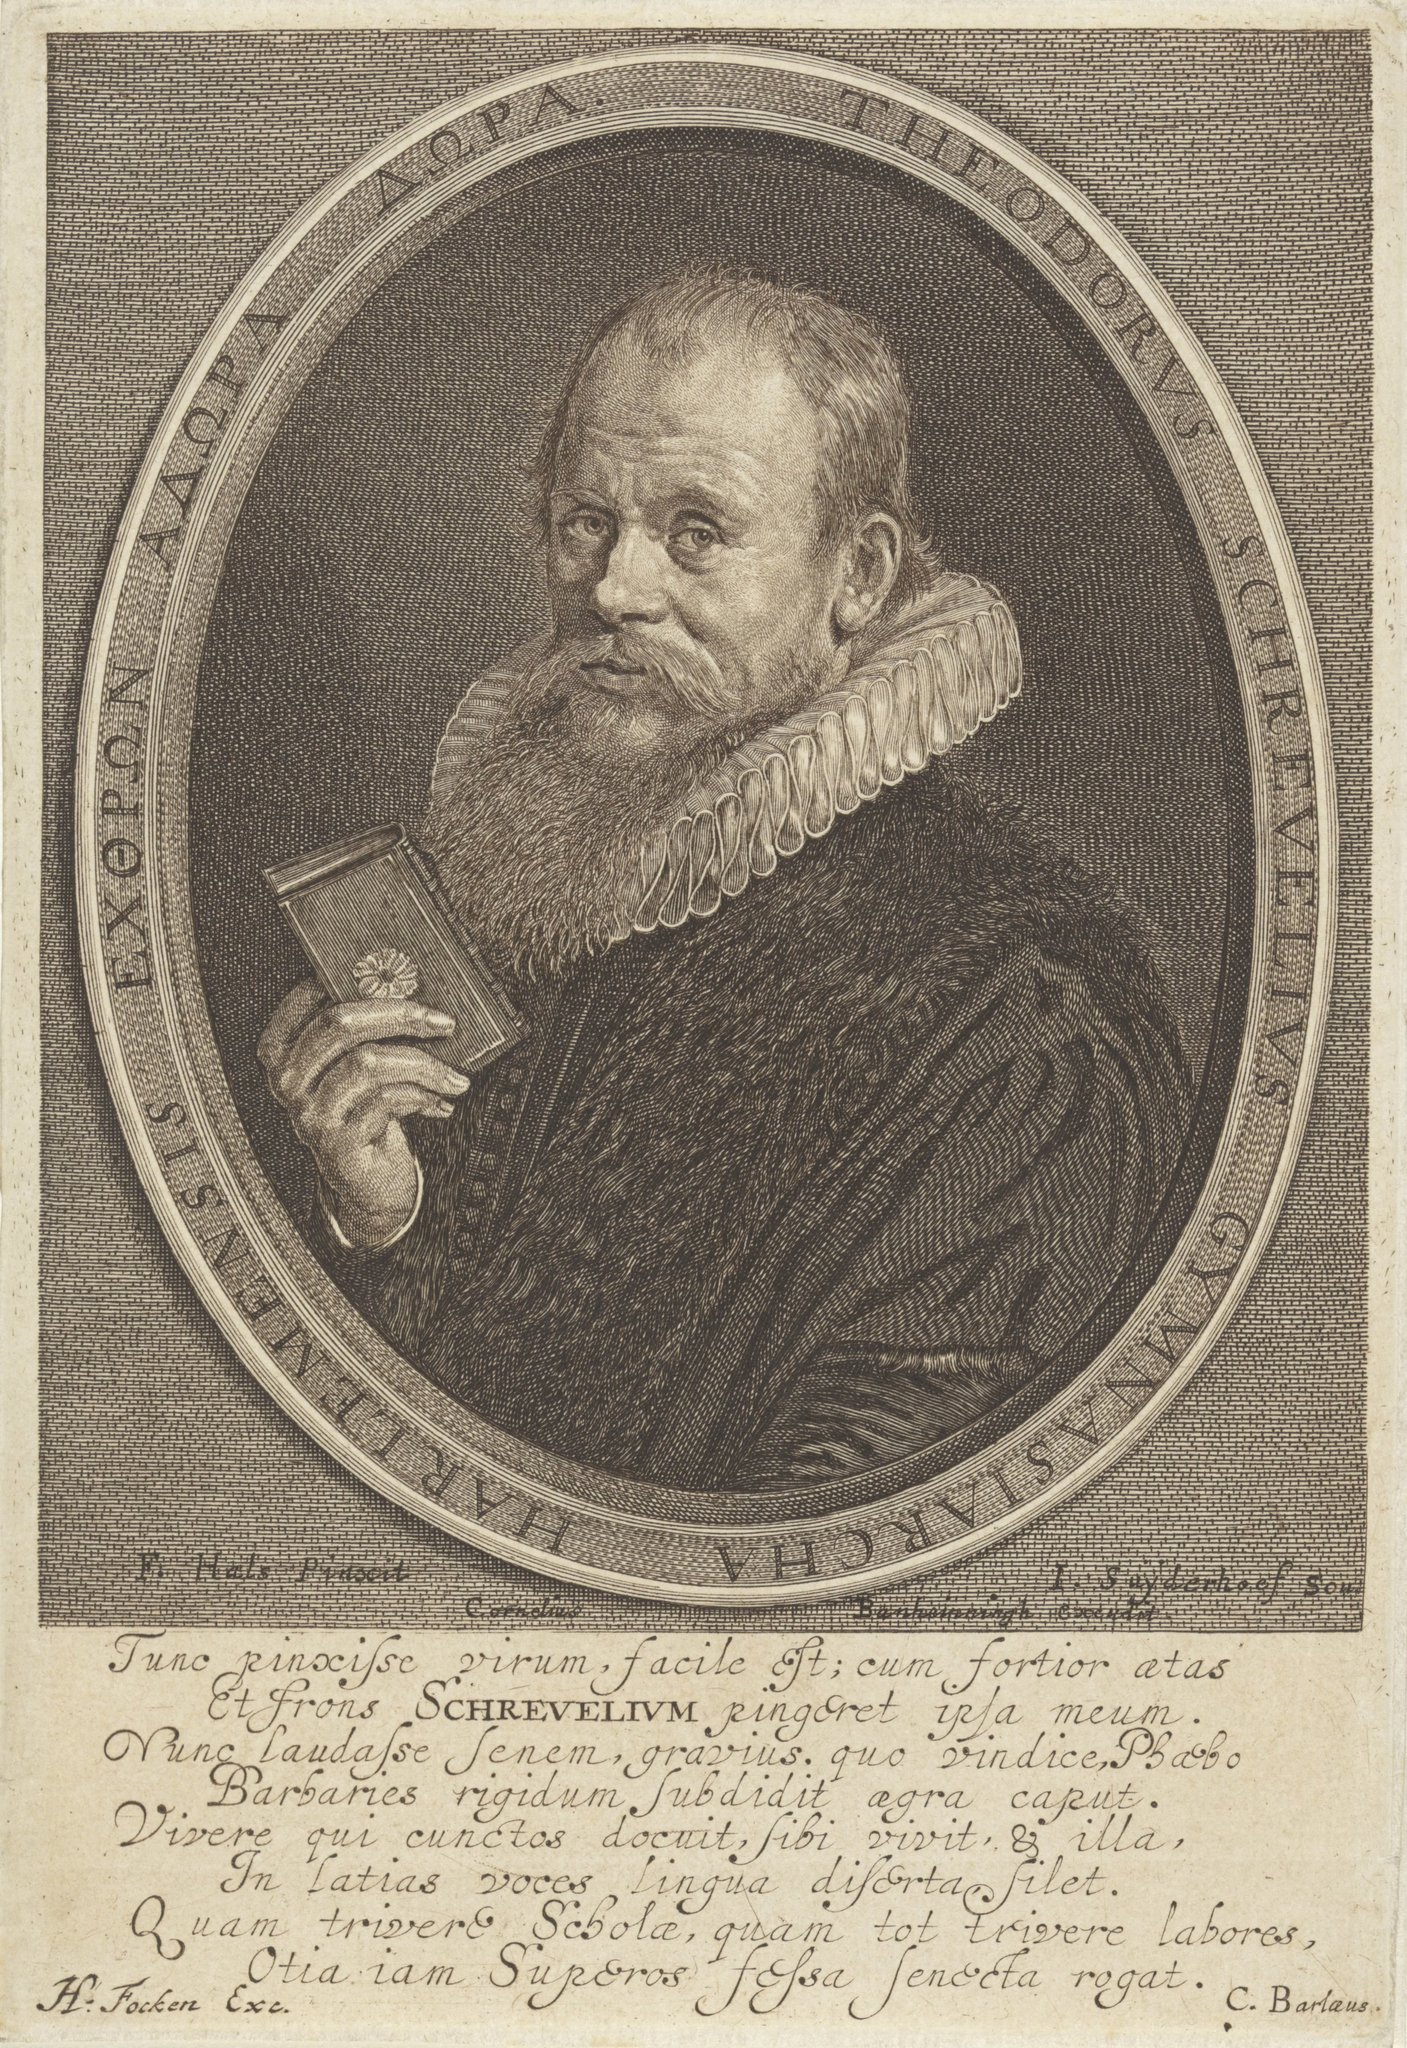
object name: print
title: Portret van Theodorus Schrevelius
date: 1623-1686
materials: paper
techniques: engraving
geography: haarlem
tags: leiden, theodorus schrevelius, book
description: Portret van Theodorus Schrevelius, rector van de Latijnse school in Haarlem. Hij houdt een boek in zijn rechterhand. Onderaan in de marge een achtregelige tekst in het Latijn.